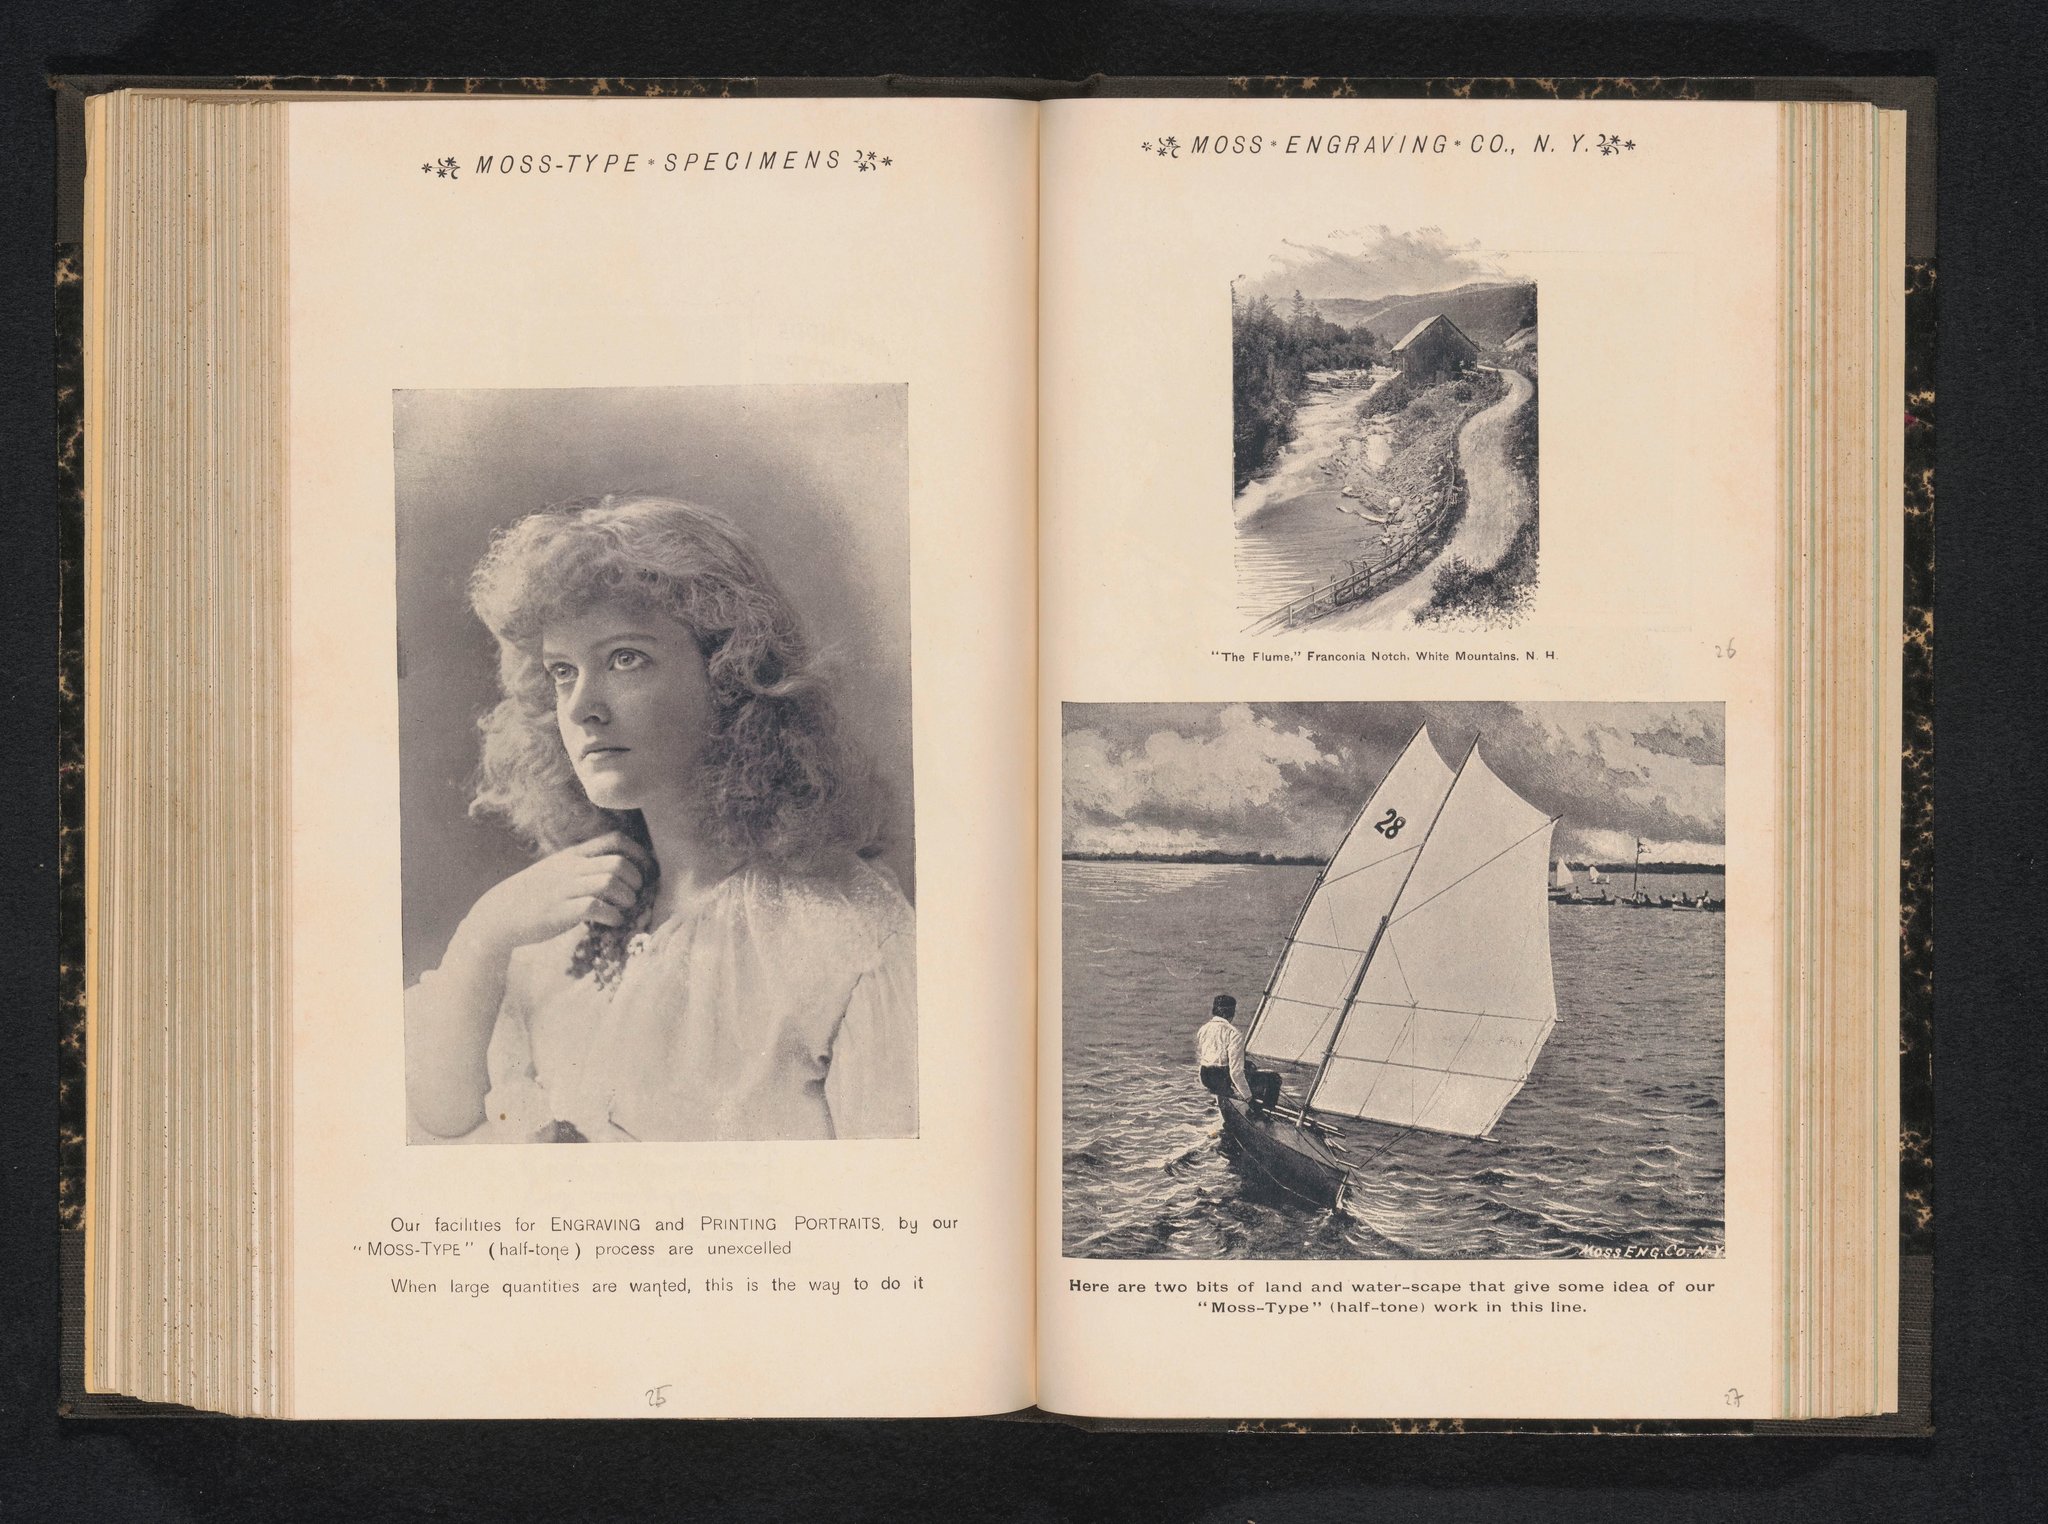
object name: photomechanical print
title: Portret van een onbekende vrouw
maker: Anonymous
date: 1887-1907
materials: paper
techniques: autotype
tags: historical persons - bb - woman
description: Prent op derde ongenummerde pagina na pagina 393.